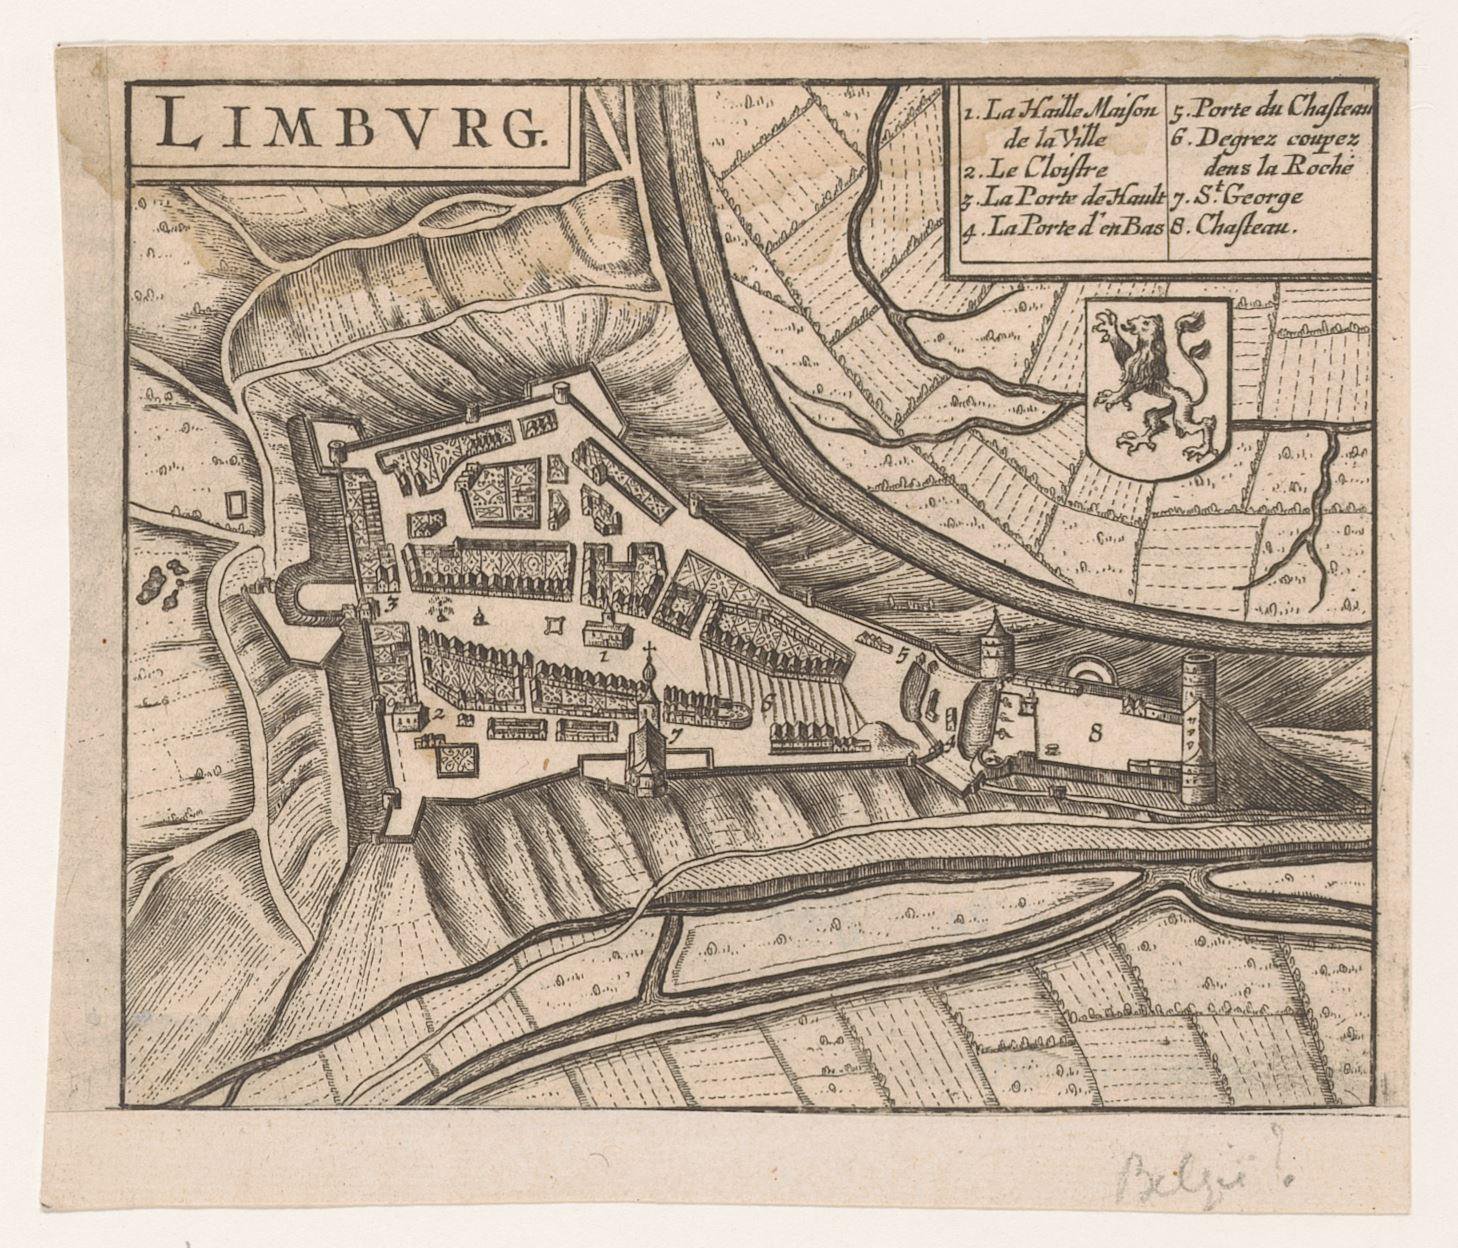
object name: book illustration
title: Limburg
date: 1652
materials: paper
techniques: etching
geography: amsterdam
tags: maps of cities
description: Plattegrond uit: Guicciardini, Lodovico. Belgicae sive Inferioris Germaniae, descriptio (...). Amsterdam: Johannes Janssonius junior, 1652. Ook in: Guicciardini, Lodovico. Belgicae sive Inferioris Germaniae (...). Amsterdam: Jacob van Meurs, 1660. Tevens gebruikt in: Beschryvingh der Neder-landen; soo uyt Louis Guicciardijn als andere vermaerde schrijvers (...). 2 dln. Amsterdam: Jacob van Meurs, 1660 (en herdruk 1662). Komt ook voor in: Caert en stedeboexken van Nederlandt. Amsterdam: Jan Janssen Brouwer, 1652. En in: Parival, J.N. de. Les delices de la Hollande. Amsterdam: Jean Bouman, 1678.